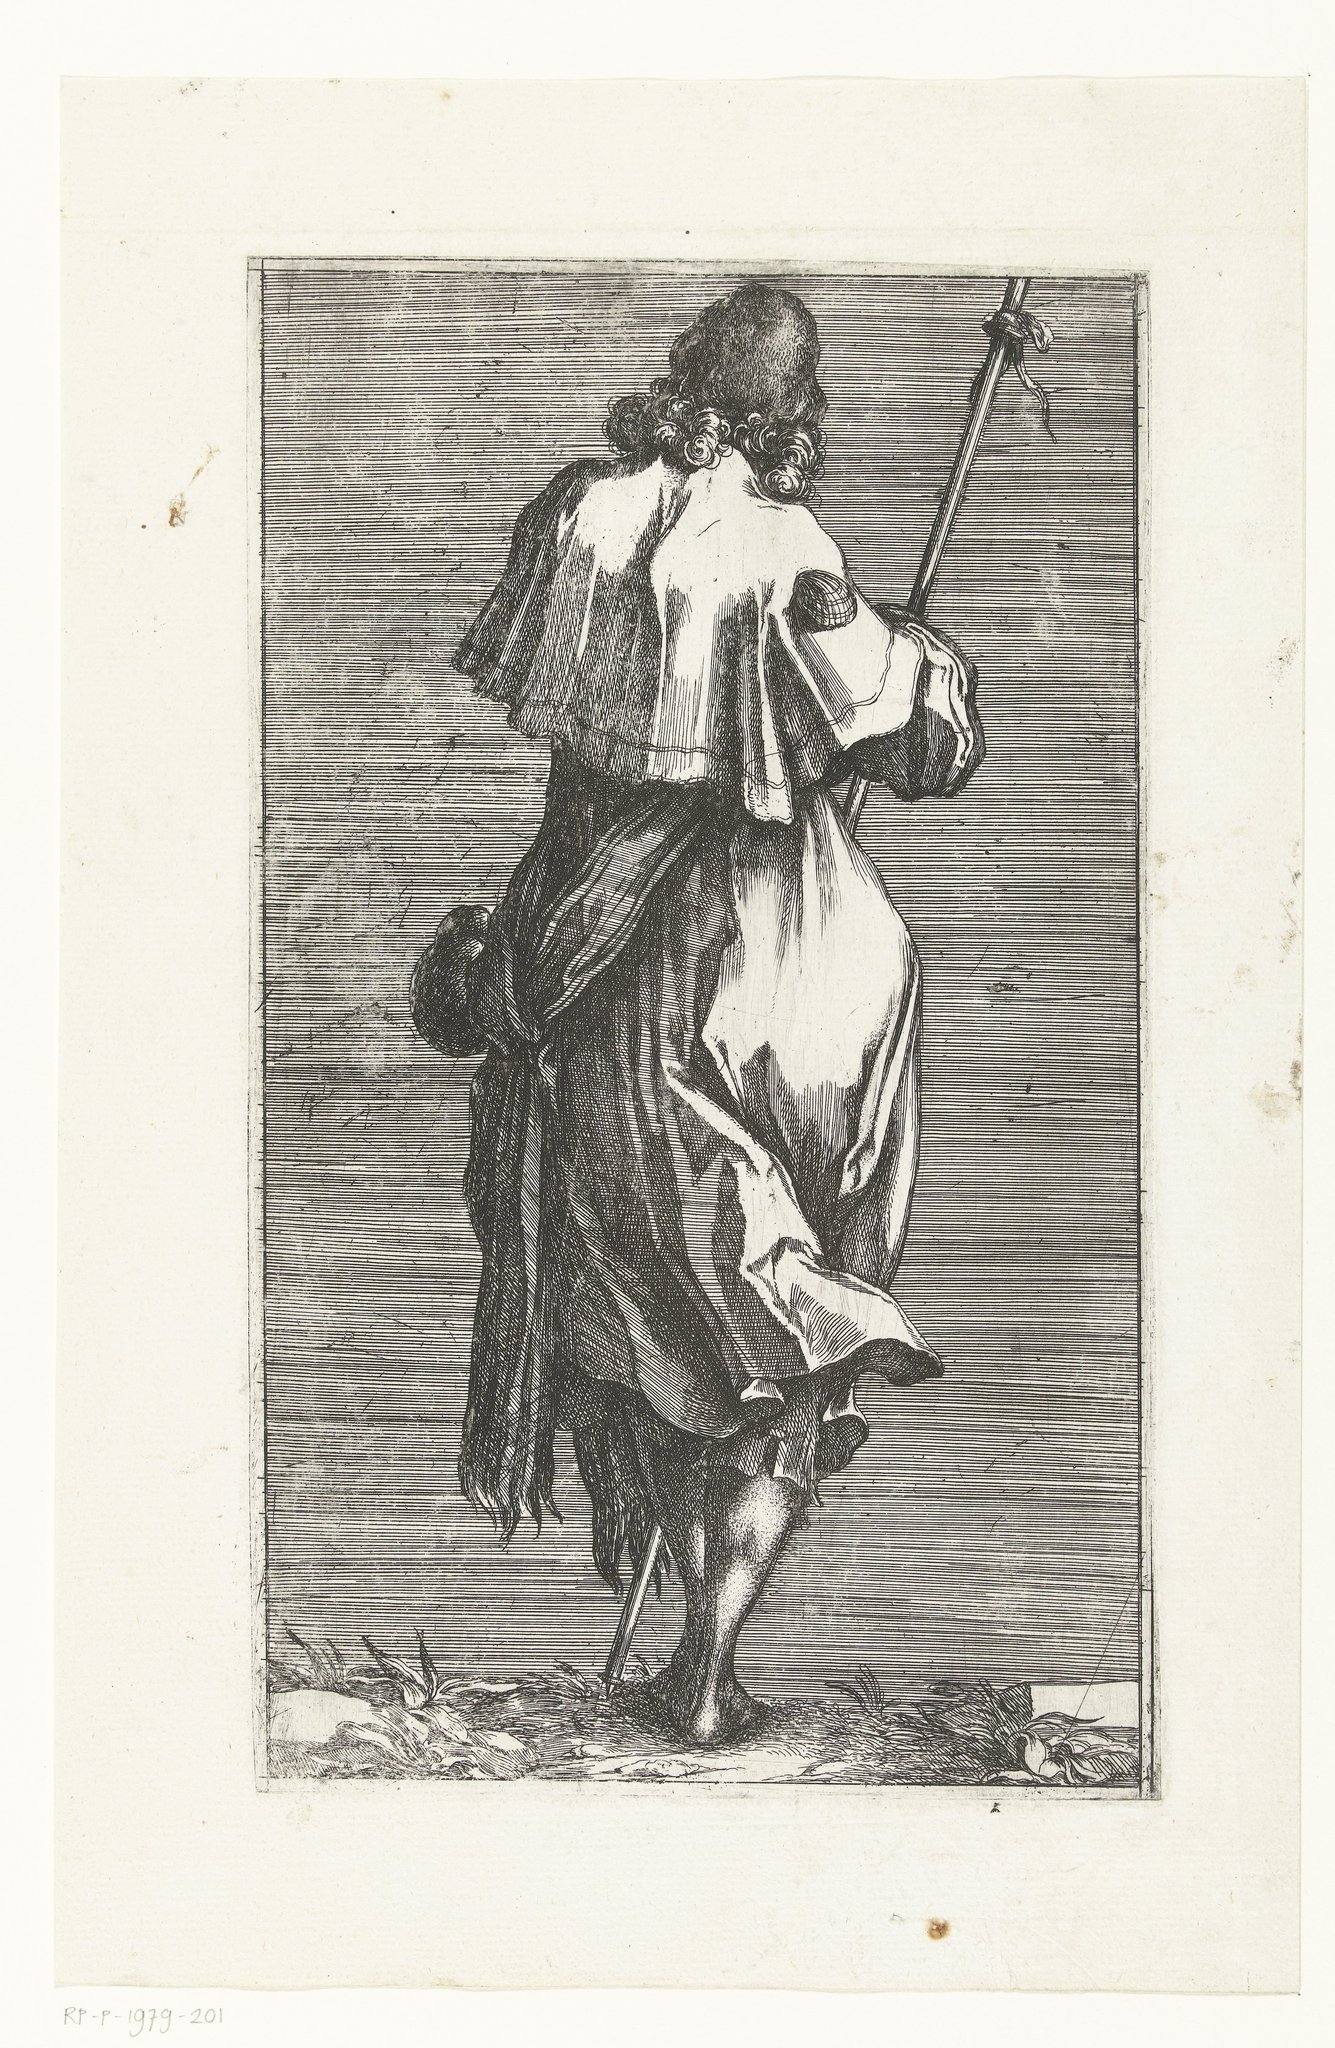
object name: print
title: Christus en de apostelen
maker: jacques bellange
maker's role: draughtsman, print maker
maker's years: 1575-1616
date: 1602-1616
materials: paper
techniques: engraving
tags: the apostle james the great; possible attributes: book, pilgrim's cloak, hat, shell, staff, and wallet, scroll, sword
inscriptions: collector's mark: Lugt 2760, collector's mark: Lugt 2228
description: De apostel Jakobus Major op de rug gezien, een pelgrimsmantel om met een Sint Jacobsschelp op de mouw.